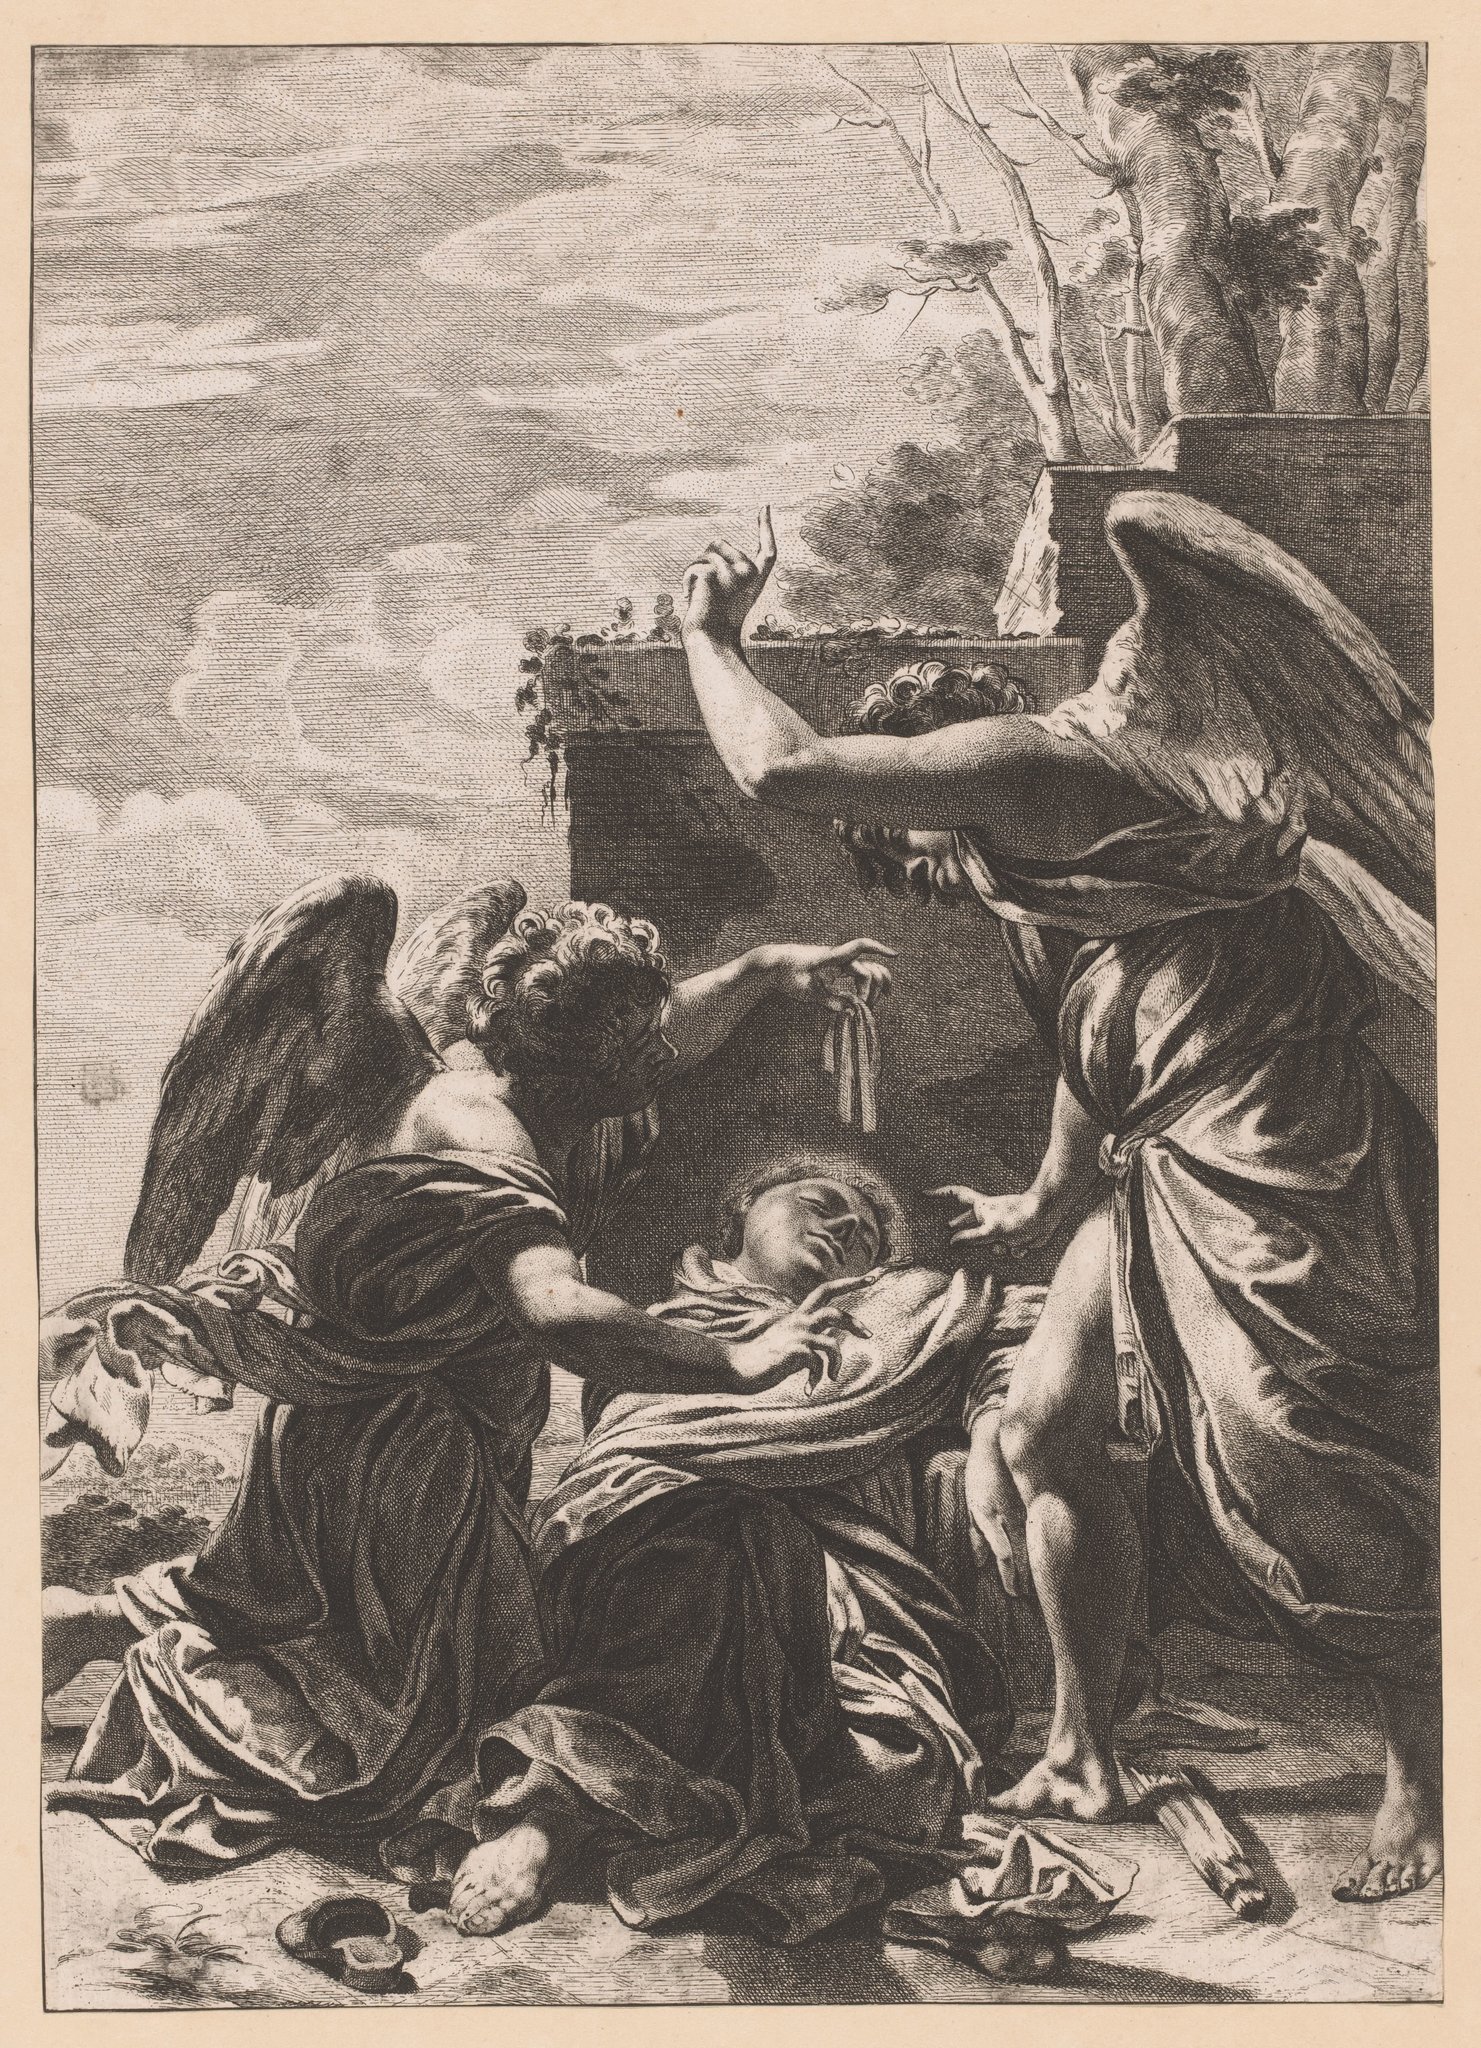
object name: print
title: Twee engelen bij een slapende of gestorven man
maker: Anonymous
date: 1630-1730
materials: paper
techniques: engraving, etching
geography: france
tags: angel guiding a soul to heaven, 'psychopompos', sleeping; unconsciousness, angels, death of human being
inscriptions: collector's mark: Lugt 240